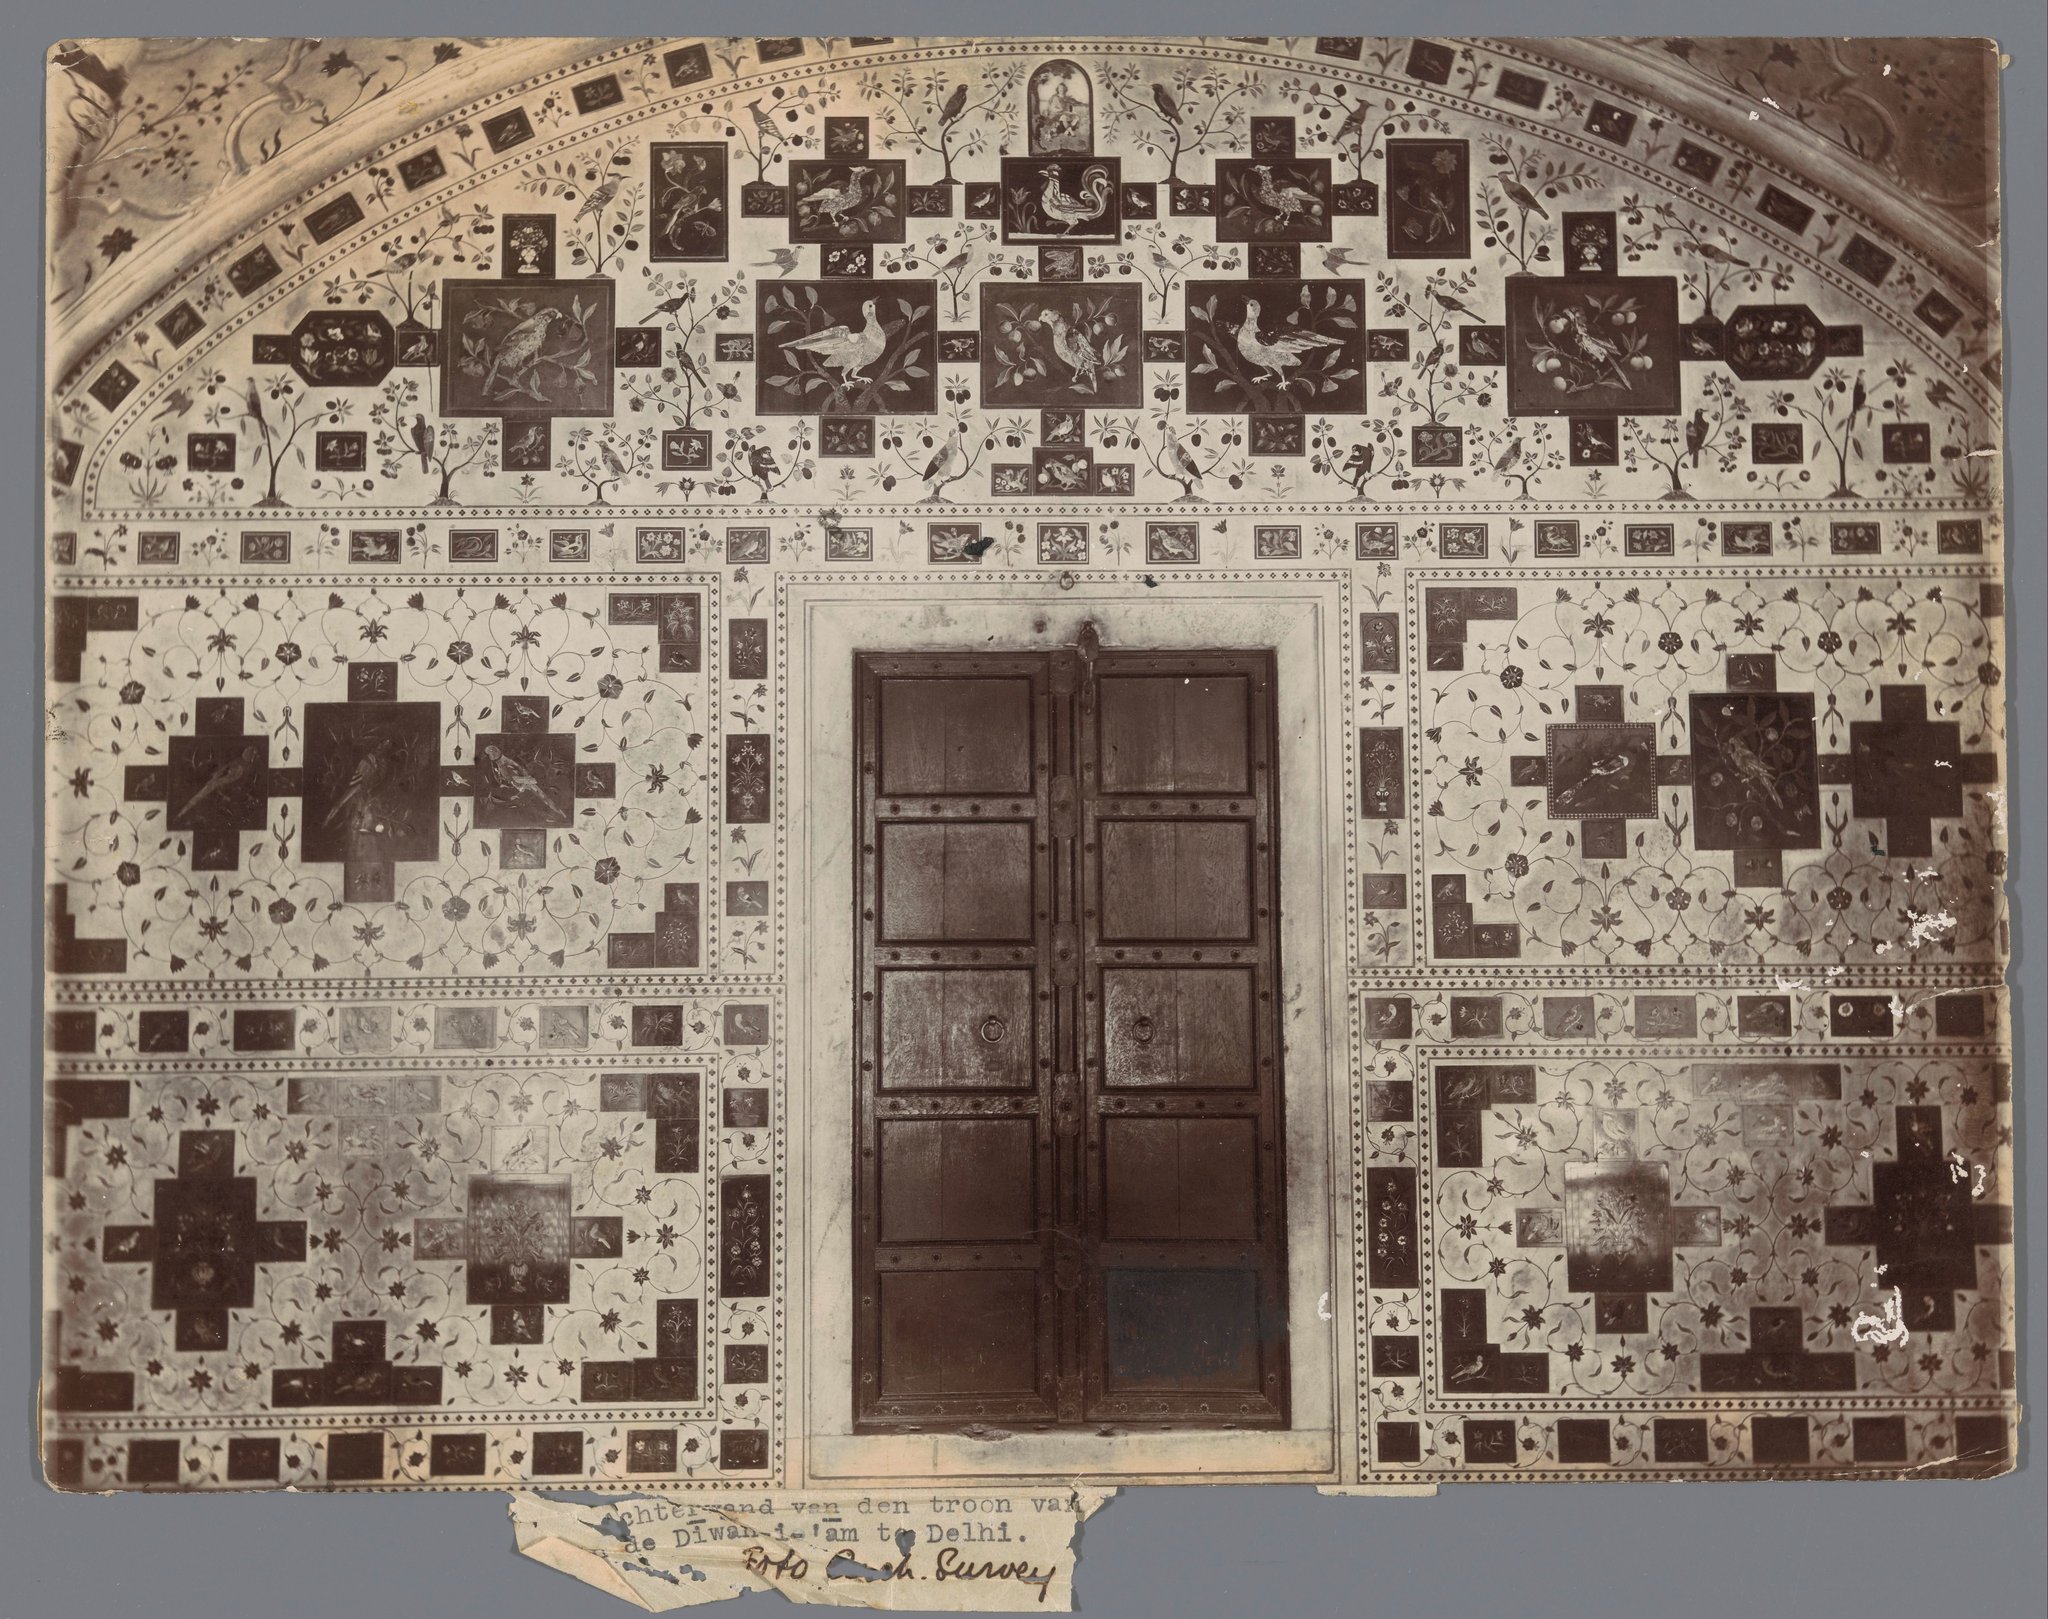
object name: photograph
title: Back wall of the throne of the Diwan-i-Am in the Red Fort at Delhi, India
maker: Anonymous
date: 1890-1920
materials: paper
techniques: gelatin silver print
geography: rode fort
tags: throne, wall-covering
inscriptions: inscription: ‘Foto Arch. Survey’, title: ‘Achterwand van den tron van [?]/ in de Diwan-i-'am te Delhi’